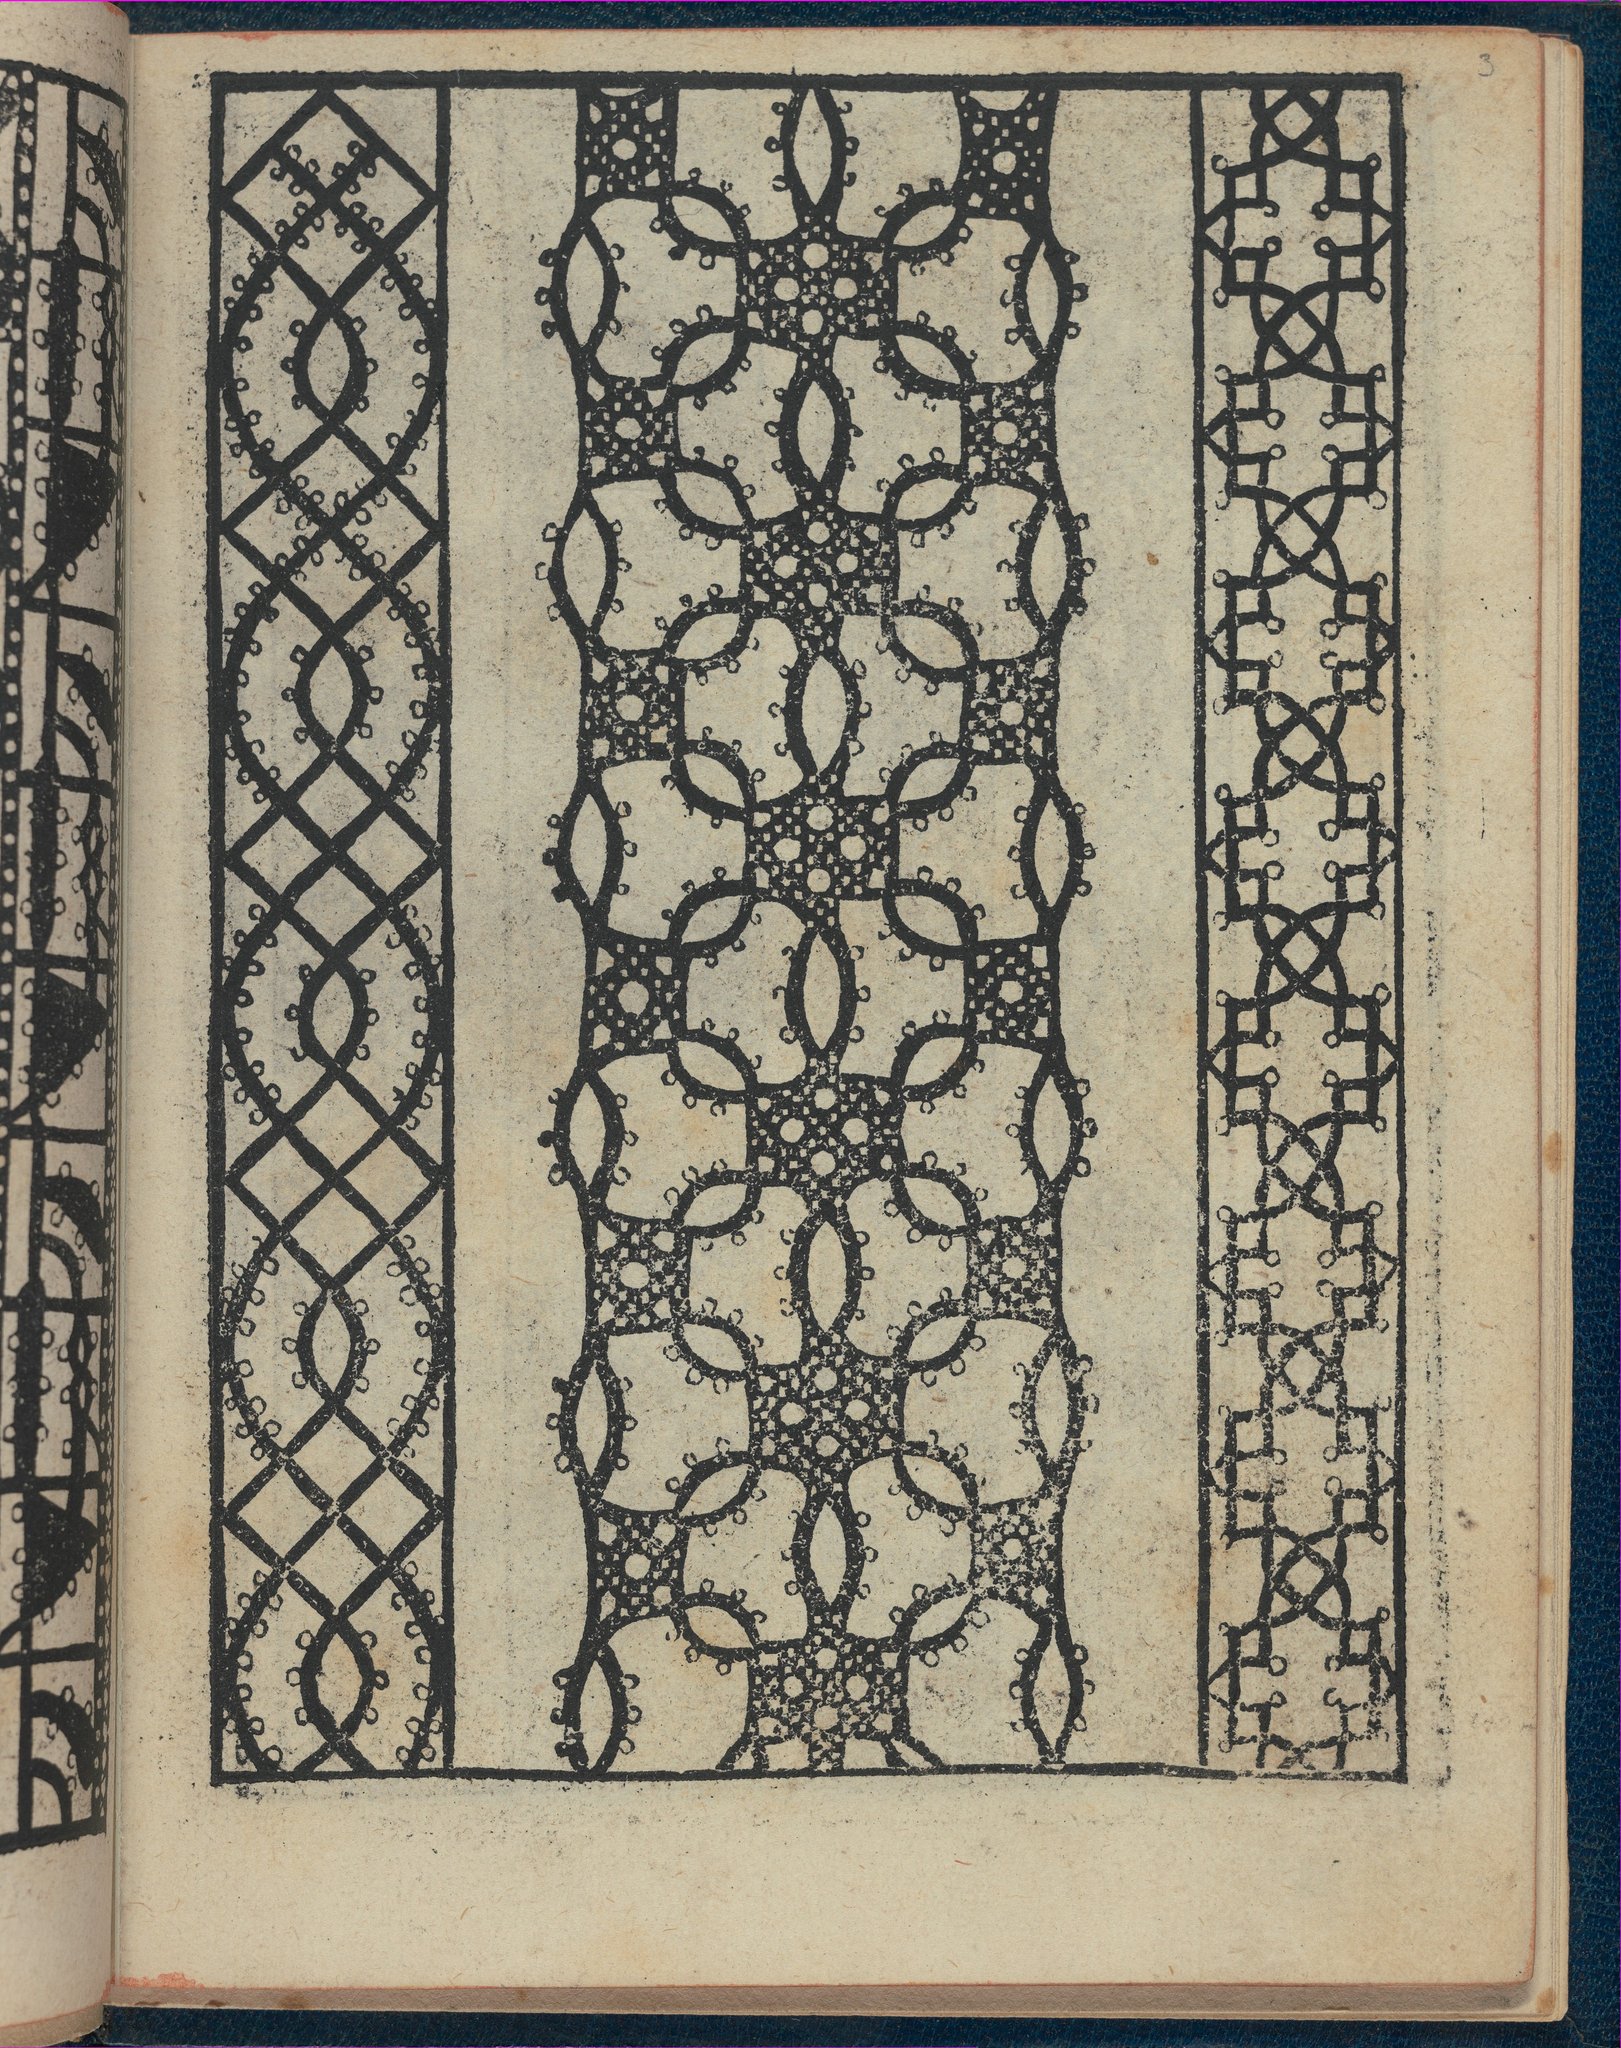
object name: book print ornament architecture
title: Le Pompe: Opera Nova, page 2 (recto)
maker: giovanni battista & marchio sessa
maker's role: publisher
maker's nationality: italian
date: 1557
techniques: woodcut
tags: ornament